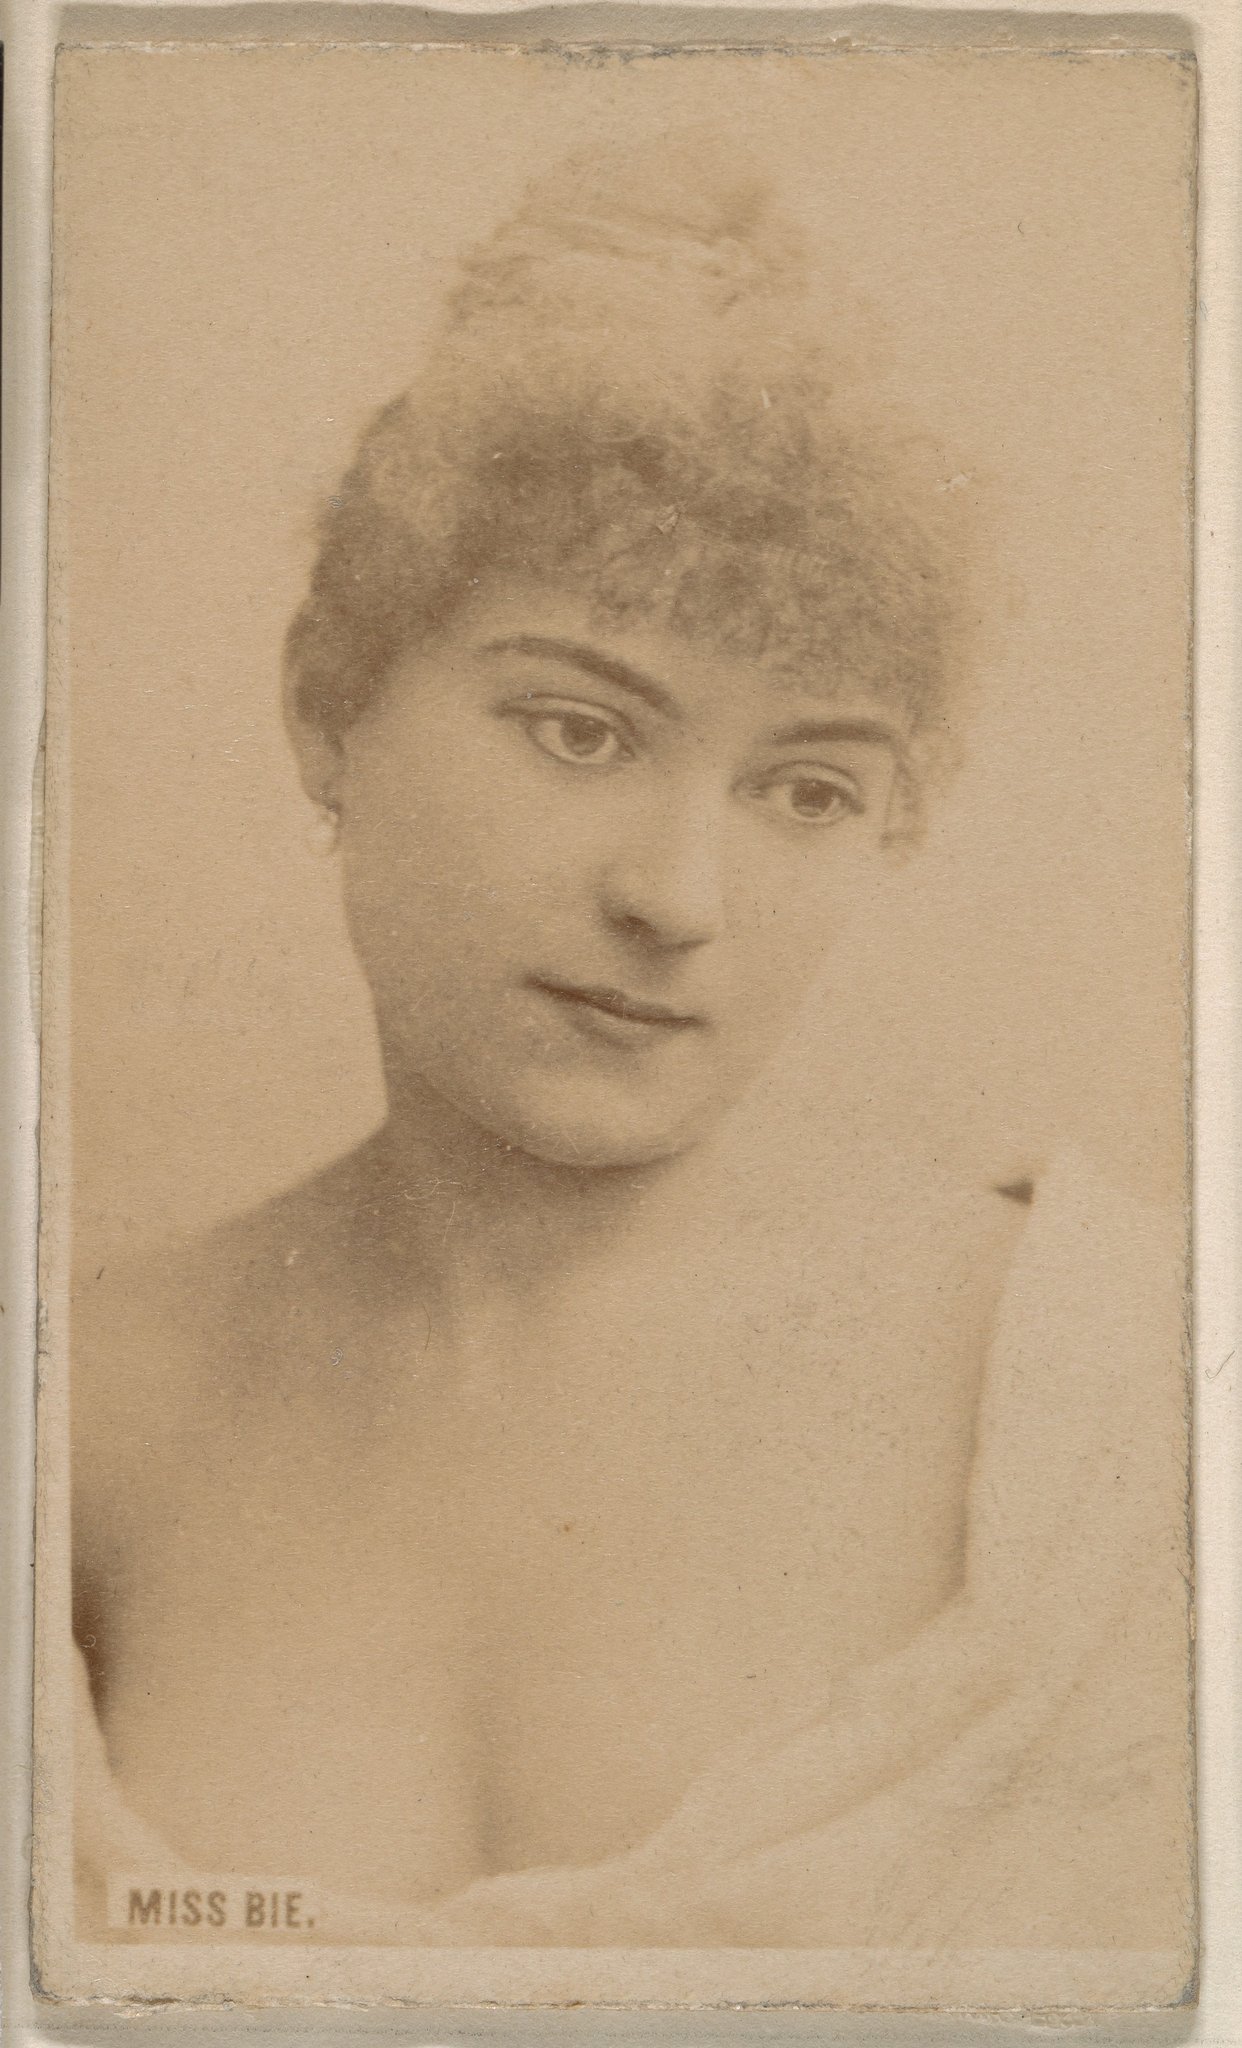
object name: photograph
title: Miss Bie, from the Actresses series (N246), Type 1, issued by Kinney Brothers to promote Sporting Extra Cigarettes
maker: kinney brothers tobacco company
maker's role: publisher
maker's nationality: american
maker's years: 1869-2011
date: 1890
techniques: albumen silver print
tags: portraits,women,actresses